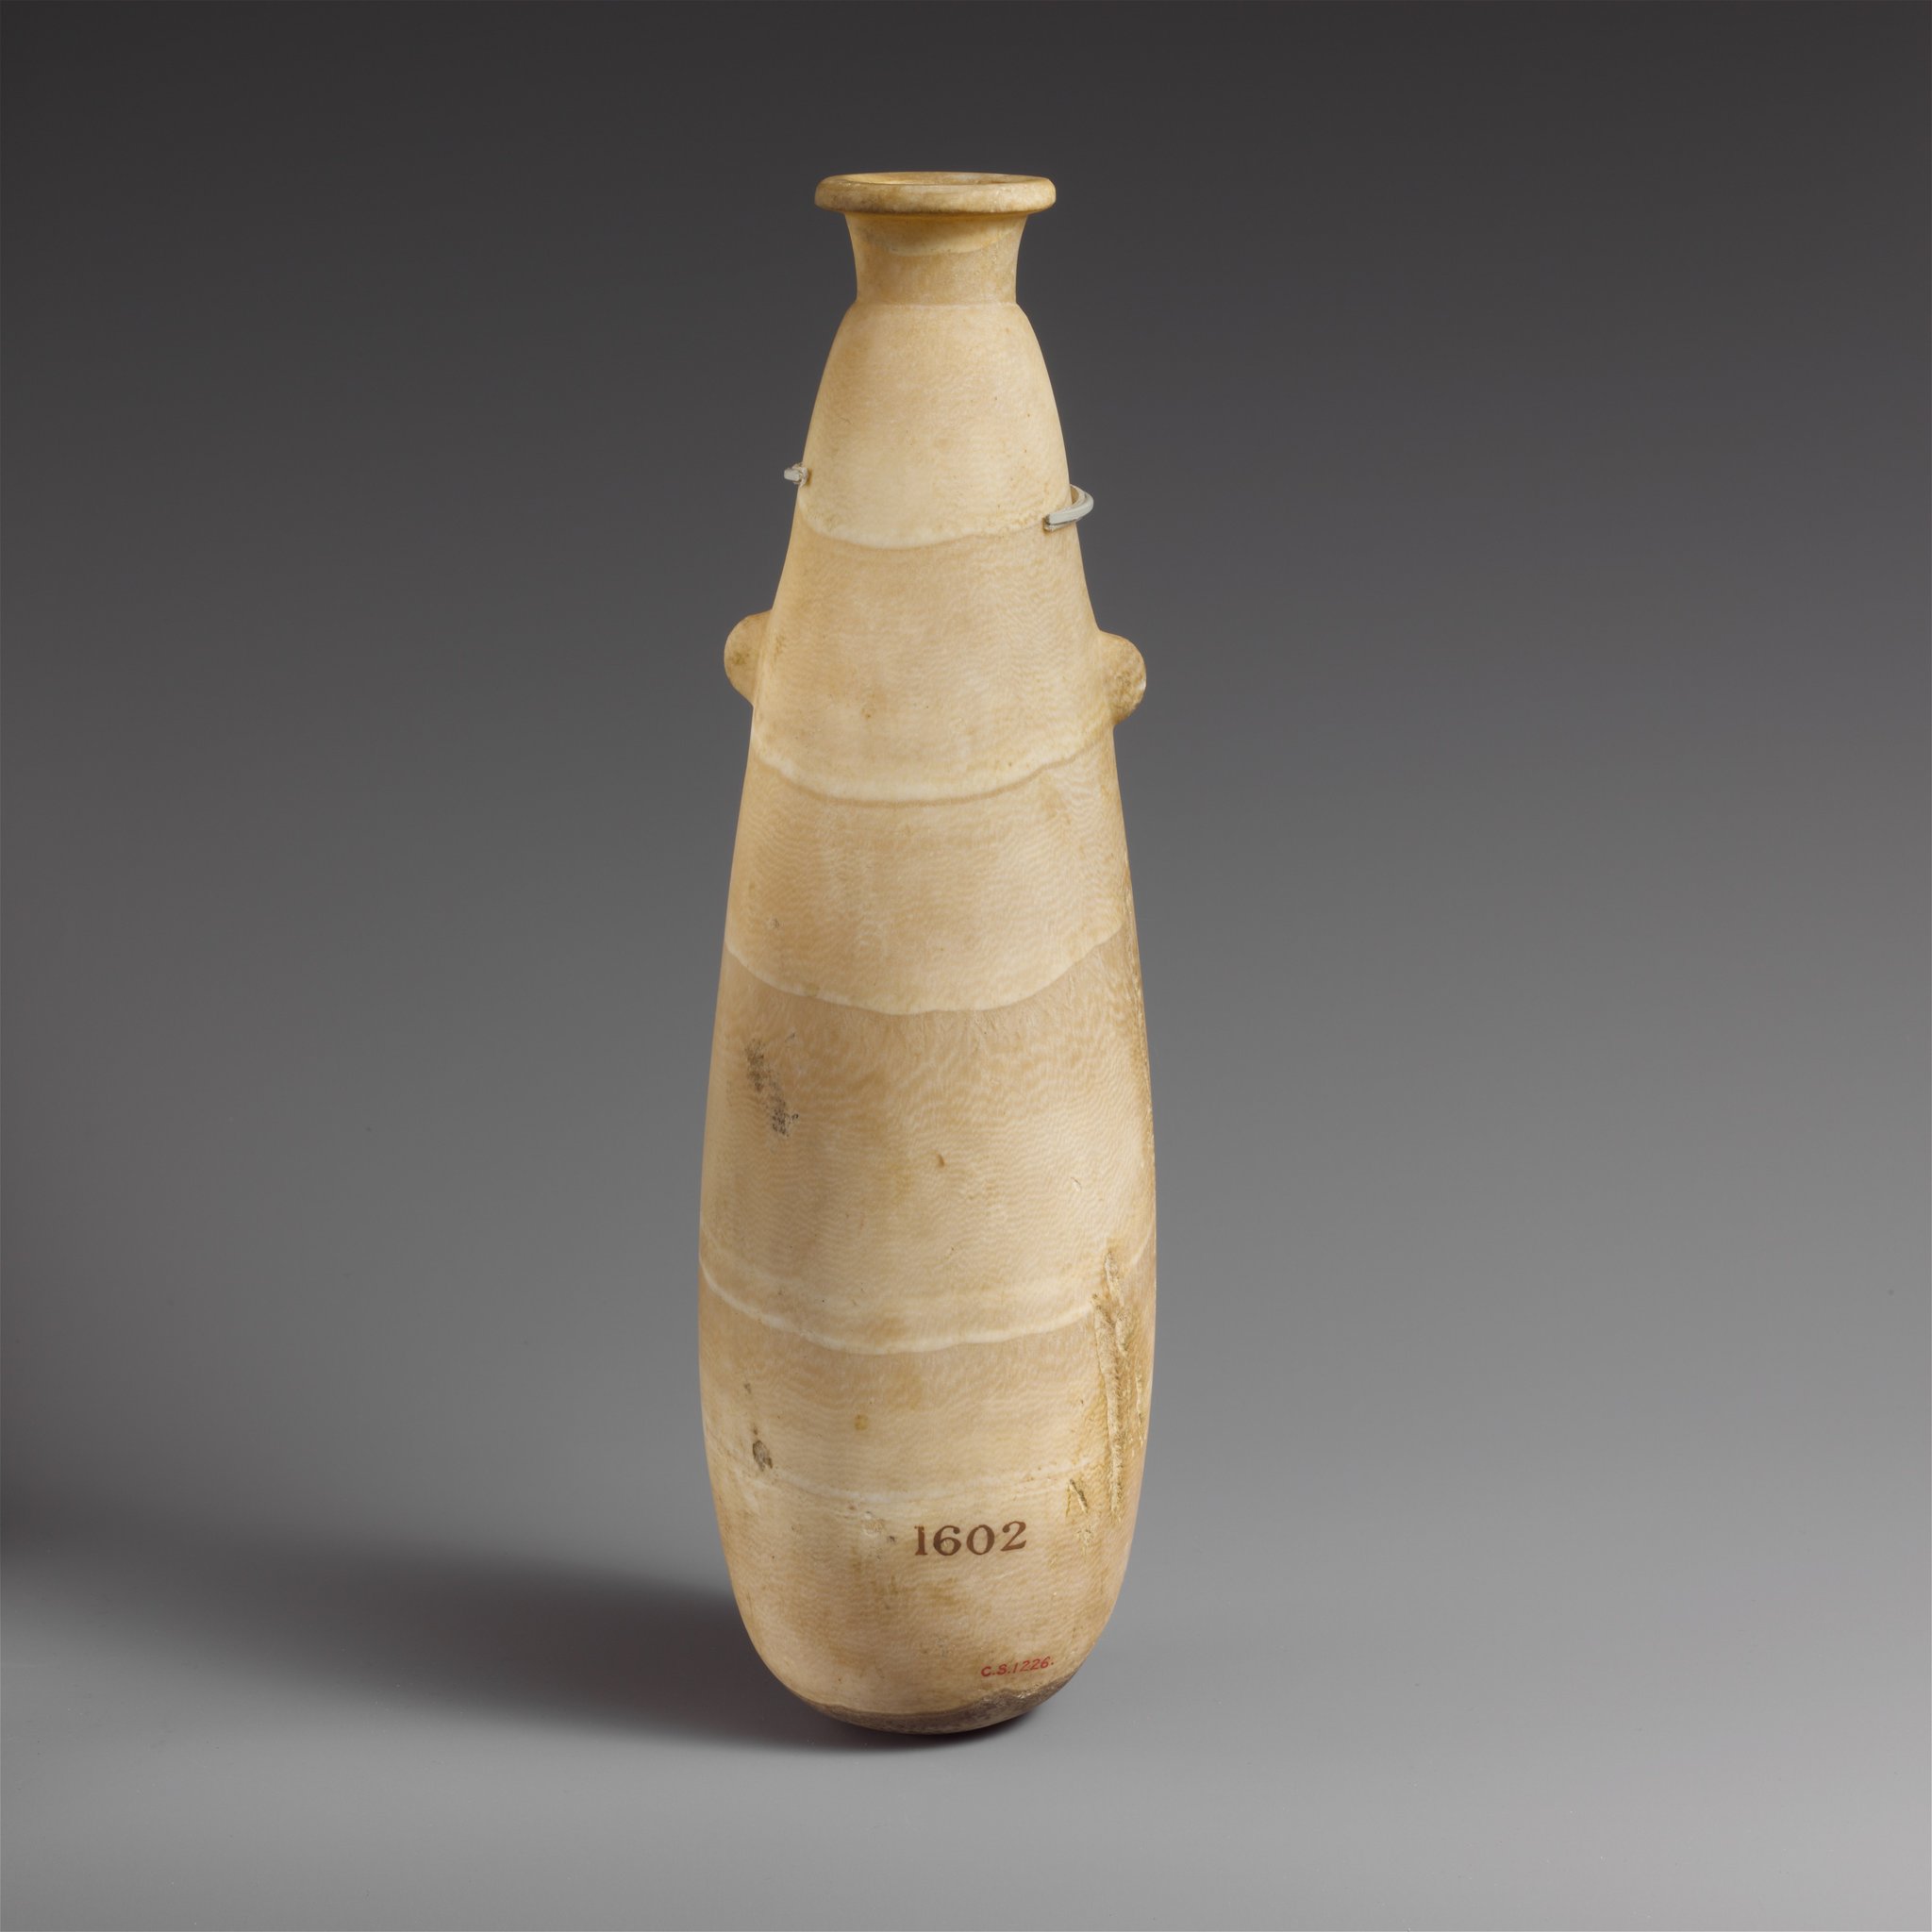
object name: alabastron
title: Alabaster alabastron (perfume vase)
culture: cypriot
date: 600-301 BCE